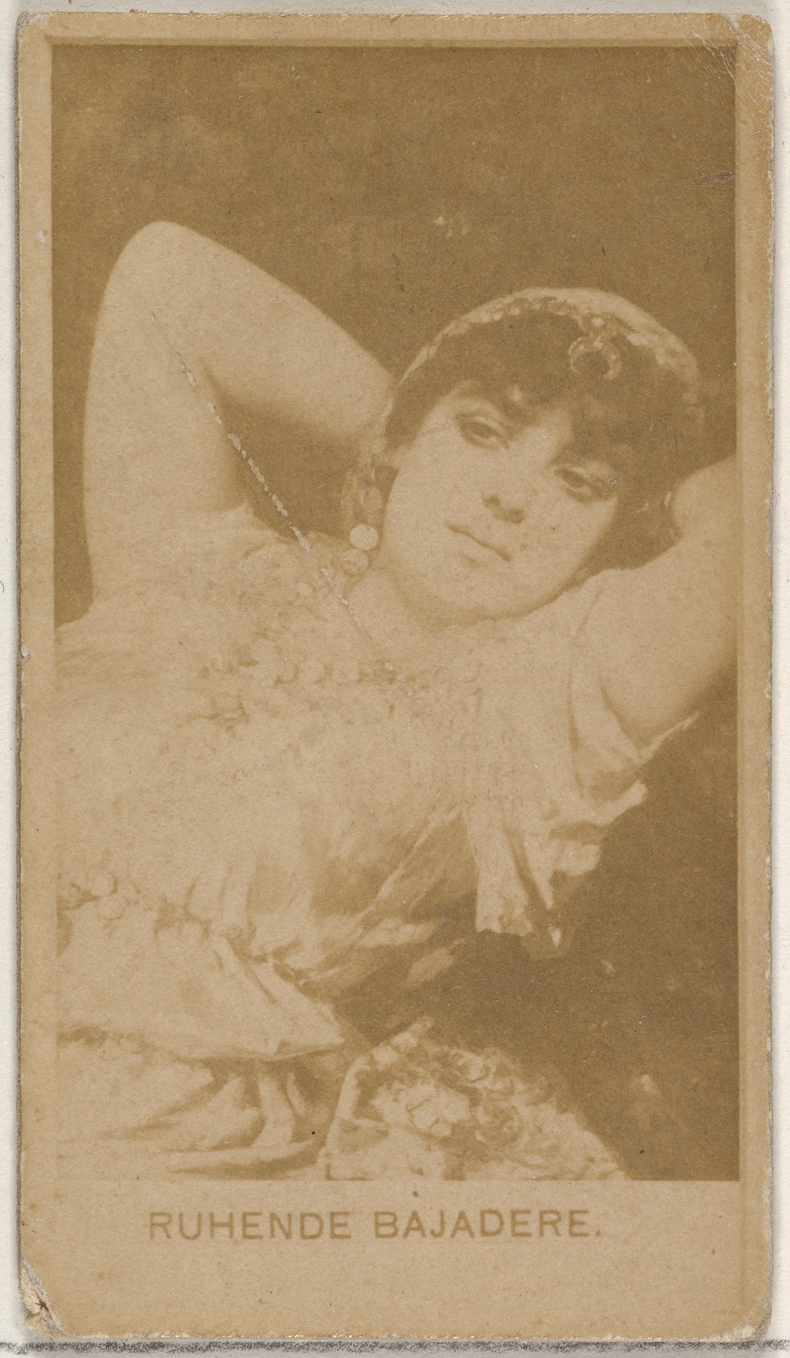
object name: photograph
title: Ruhende Bajadere, from the Actors and Actresses series (N45, Type 8) for Virginia Brights Cigarettes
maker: allen & ginter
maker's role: publisher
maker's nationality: american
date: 1888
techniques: albumen silver print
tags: portraits,women,actresses